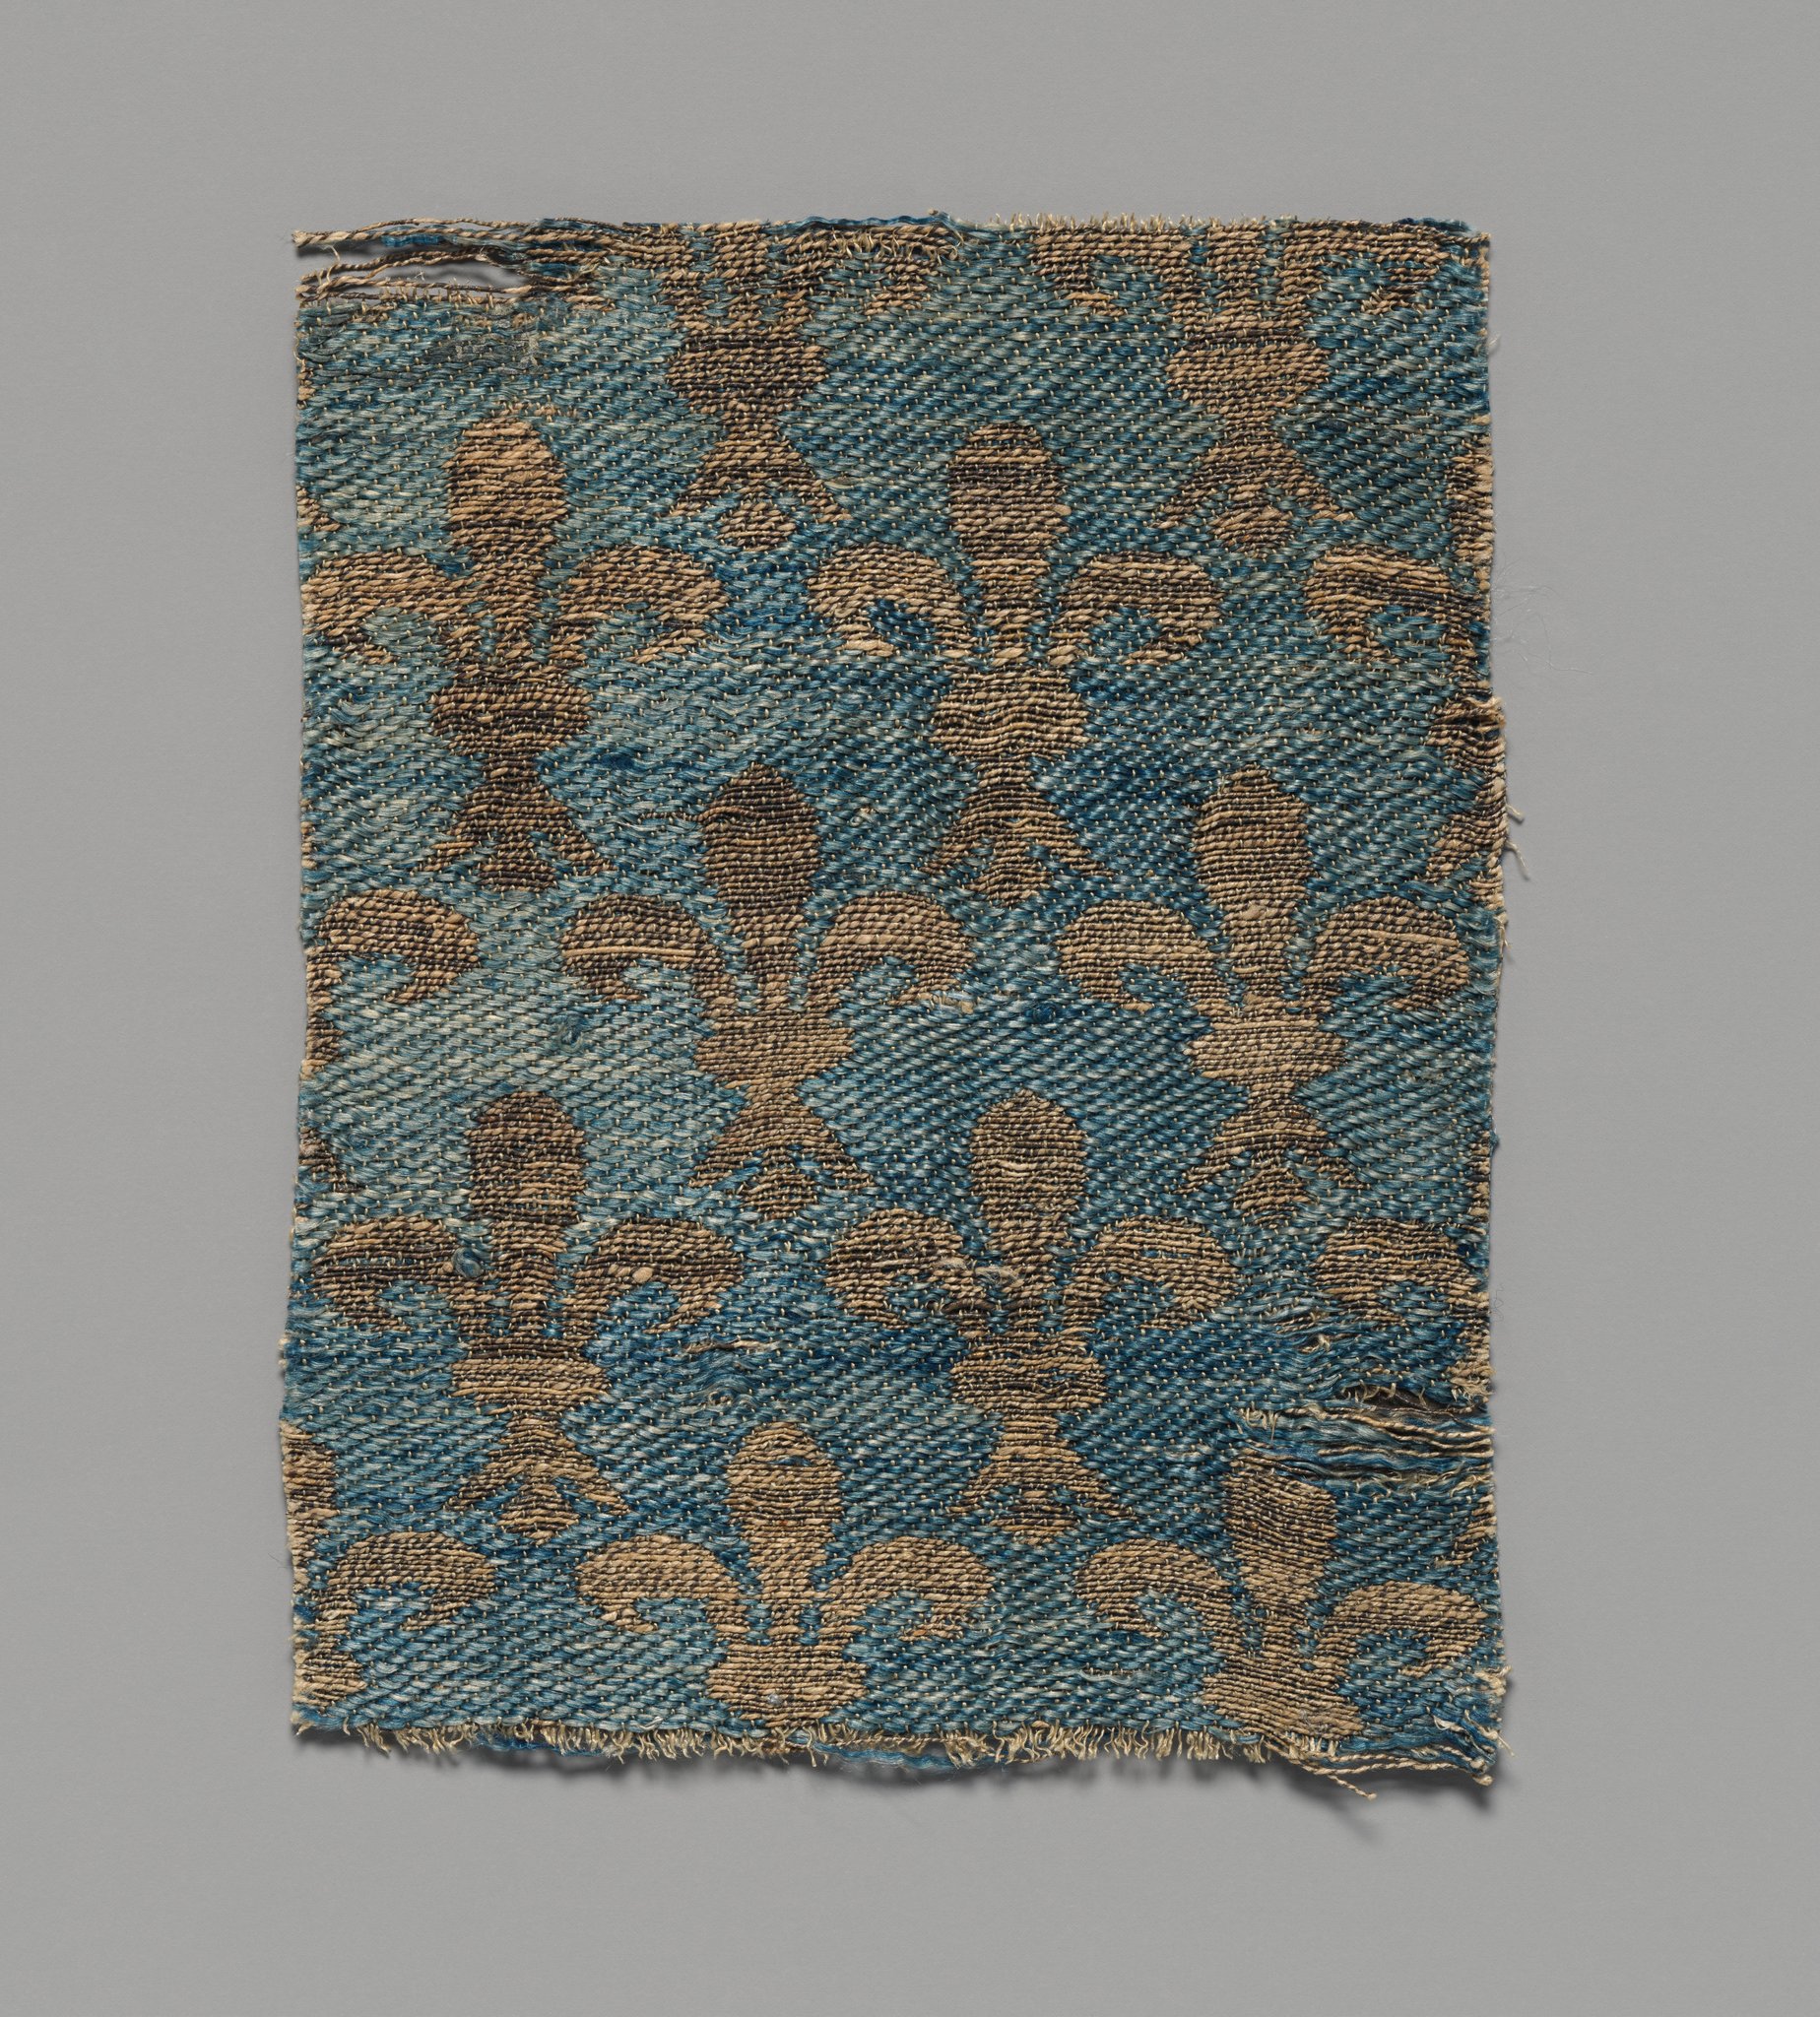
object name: textile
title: Textile with Brocade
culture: french or italian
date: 1201-1400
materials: metal thread, silk